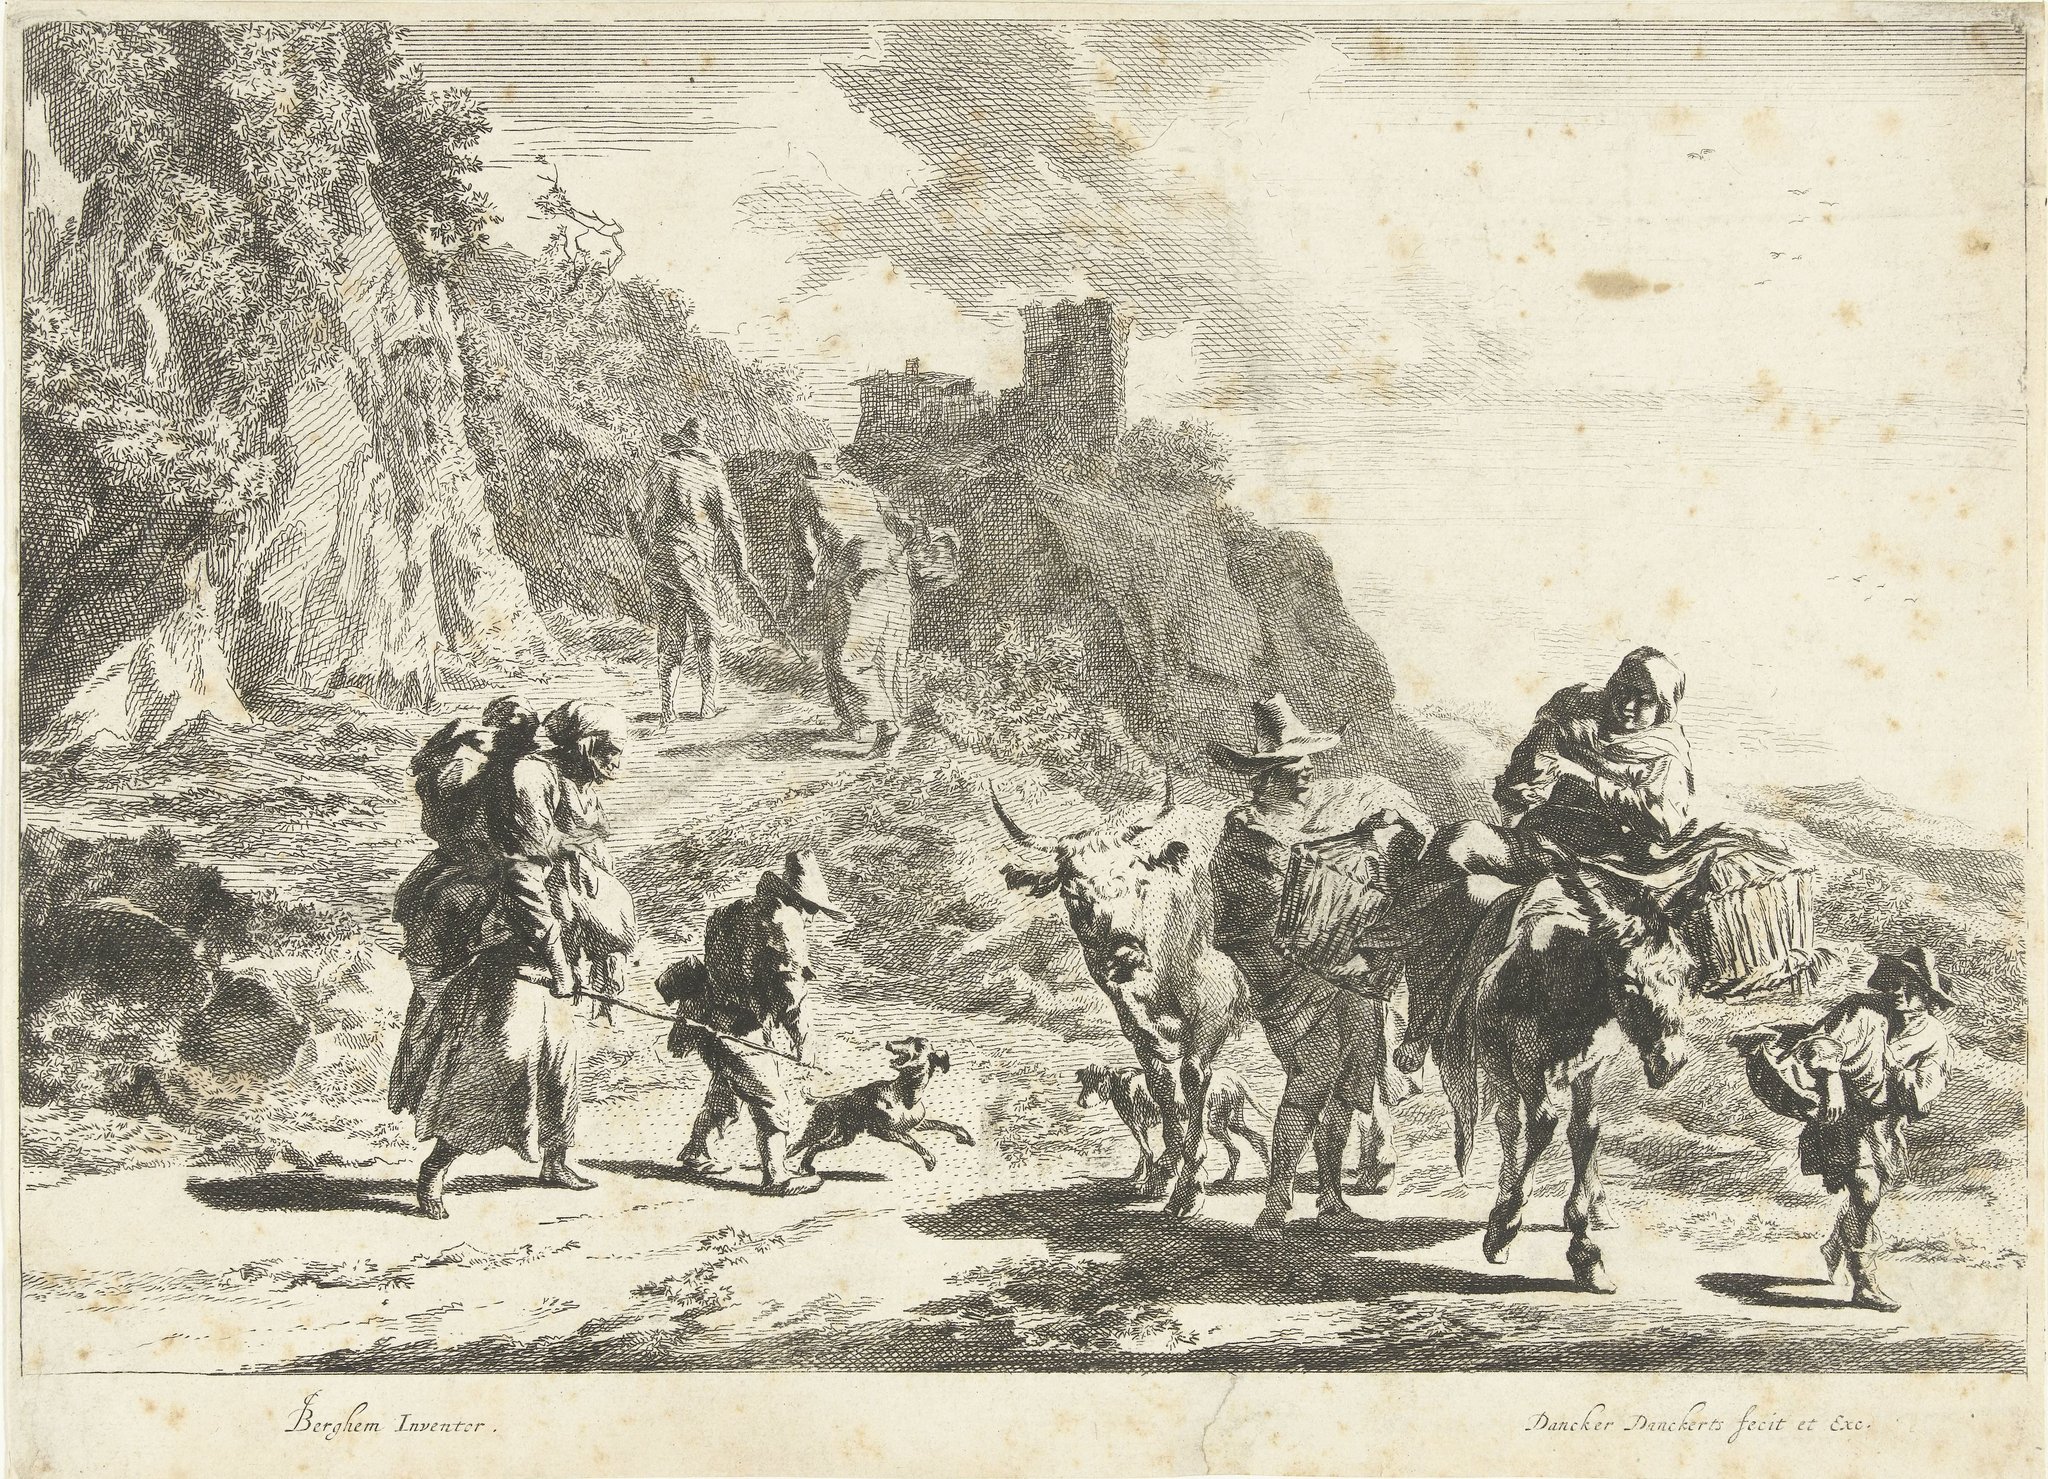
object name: print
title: Vrouw op bepakte ezel, man met koe en andere reizigers in berglandschap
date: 1643-1666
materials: paper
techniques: etching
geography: amsterdam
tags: herding, herdsman, herdswoman, shepherd, shepherdess, cowherd, etc., rocks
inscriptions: inscription: ‘Boek 41 N 34-41 met de volgende vi ... [moeilijk leesbaar]’, collector's mark: Lugt 11, collector's mark: Lugt 10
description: Prent uit serie van zes landschappen naar ontwerp van Nicolaes Pietersz. Berchem. Beschrijving bij Hollstein wijkt af van voorstelling, slechts de herderin zit op een rijdier.